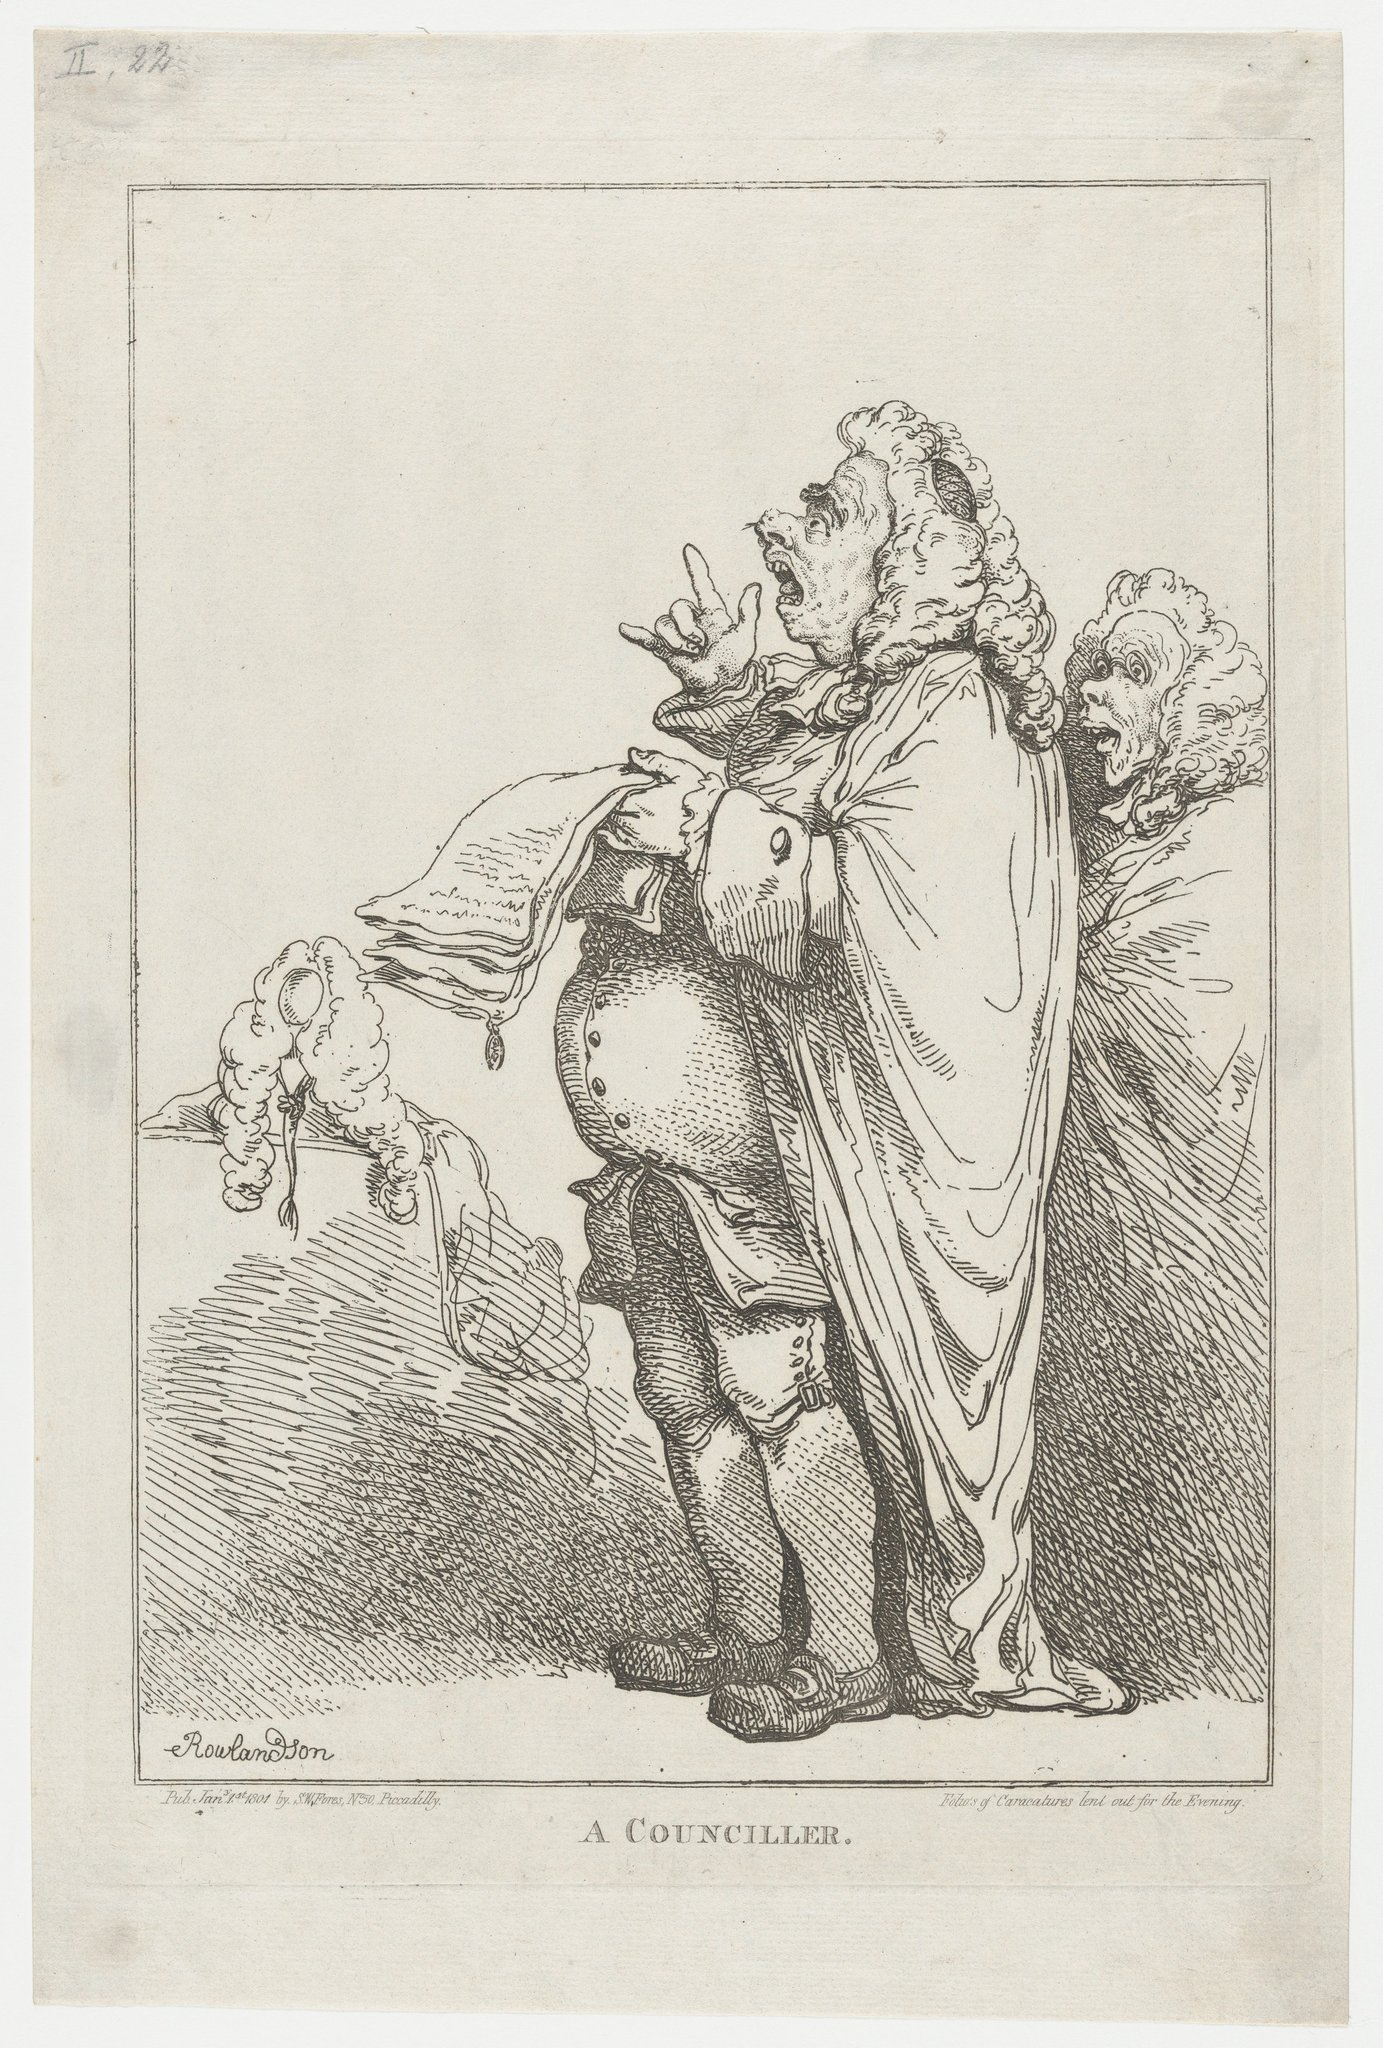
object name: print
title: A Counciller [sic]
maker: thomas rowlandson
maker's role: artist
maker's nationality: british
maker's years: 1757-1827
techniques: etching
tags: men,profiles